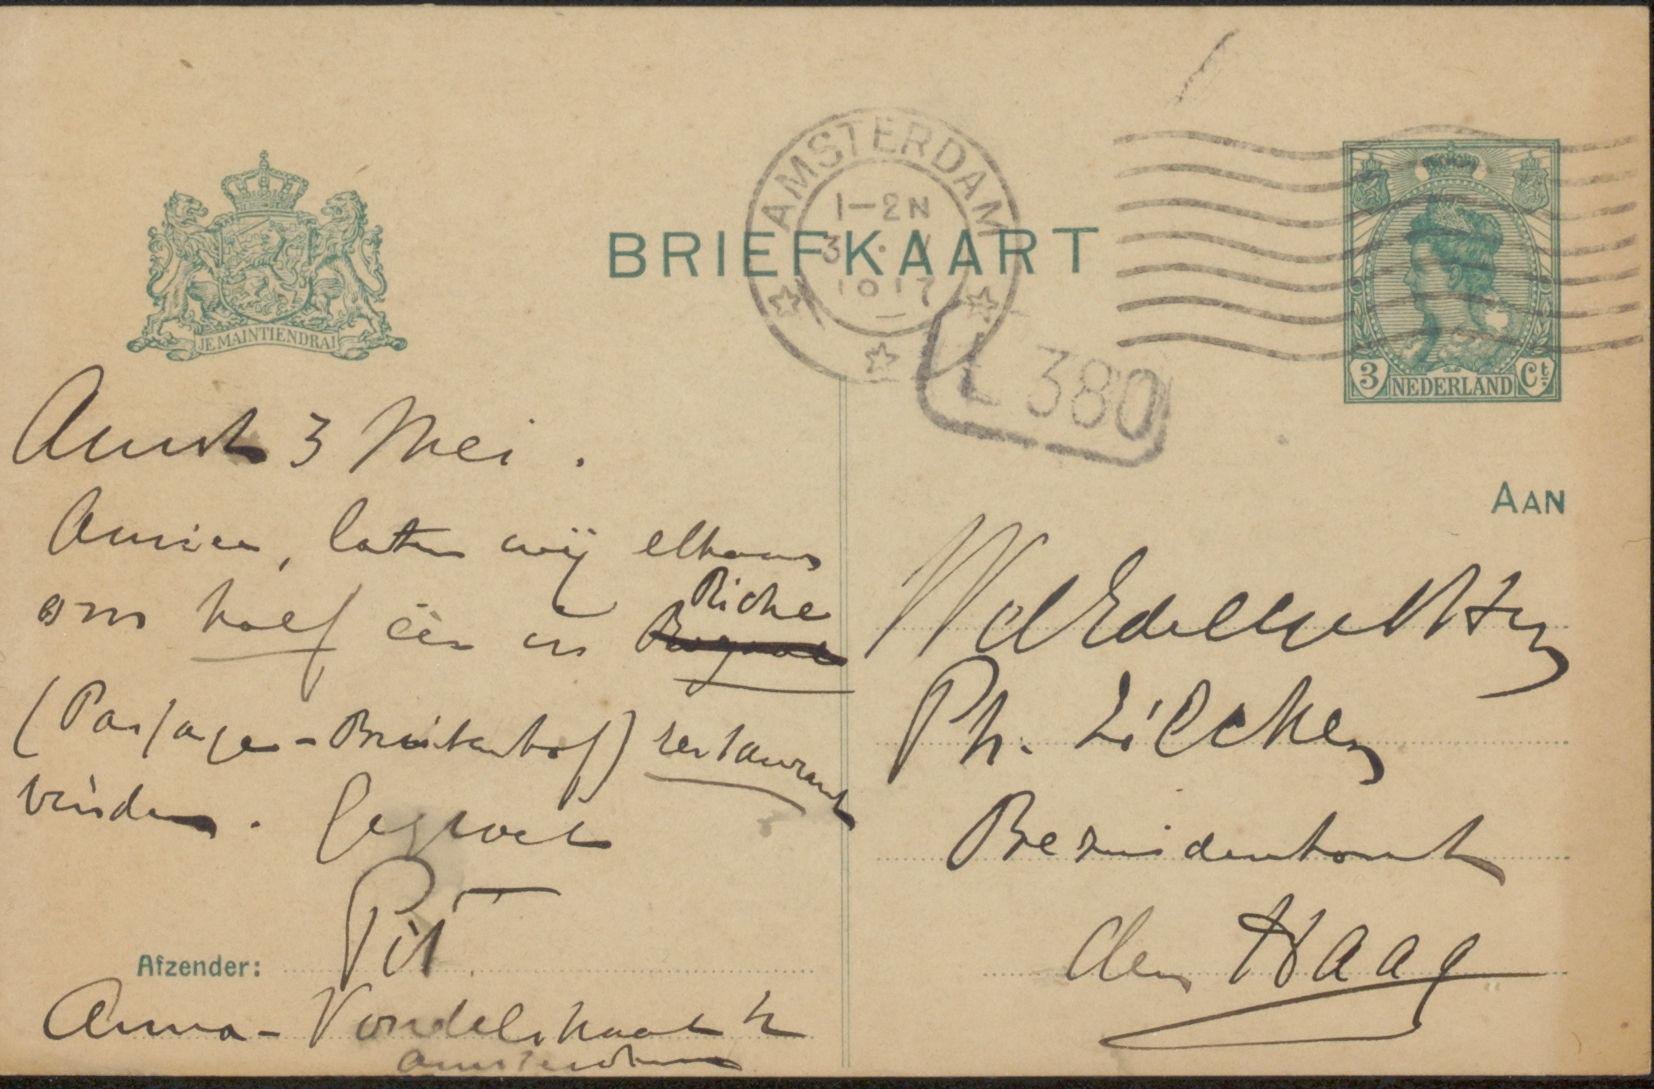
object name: postcard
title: Briefkaart aan Philip Zilcken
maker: adriaan pit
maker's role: print maker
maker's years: 1860-1944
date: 1917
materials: cardboard, ink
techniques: pen, writing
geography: amsterdam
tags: the hague, painter, draughtsman, philip zilcken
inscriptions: collector's mark: ‘RPK’